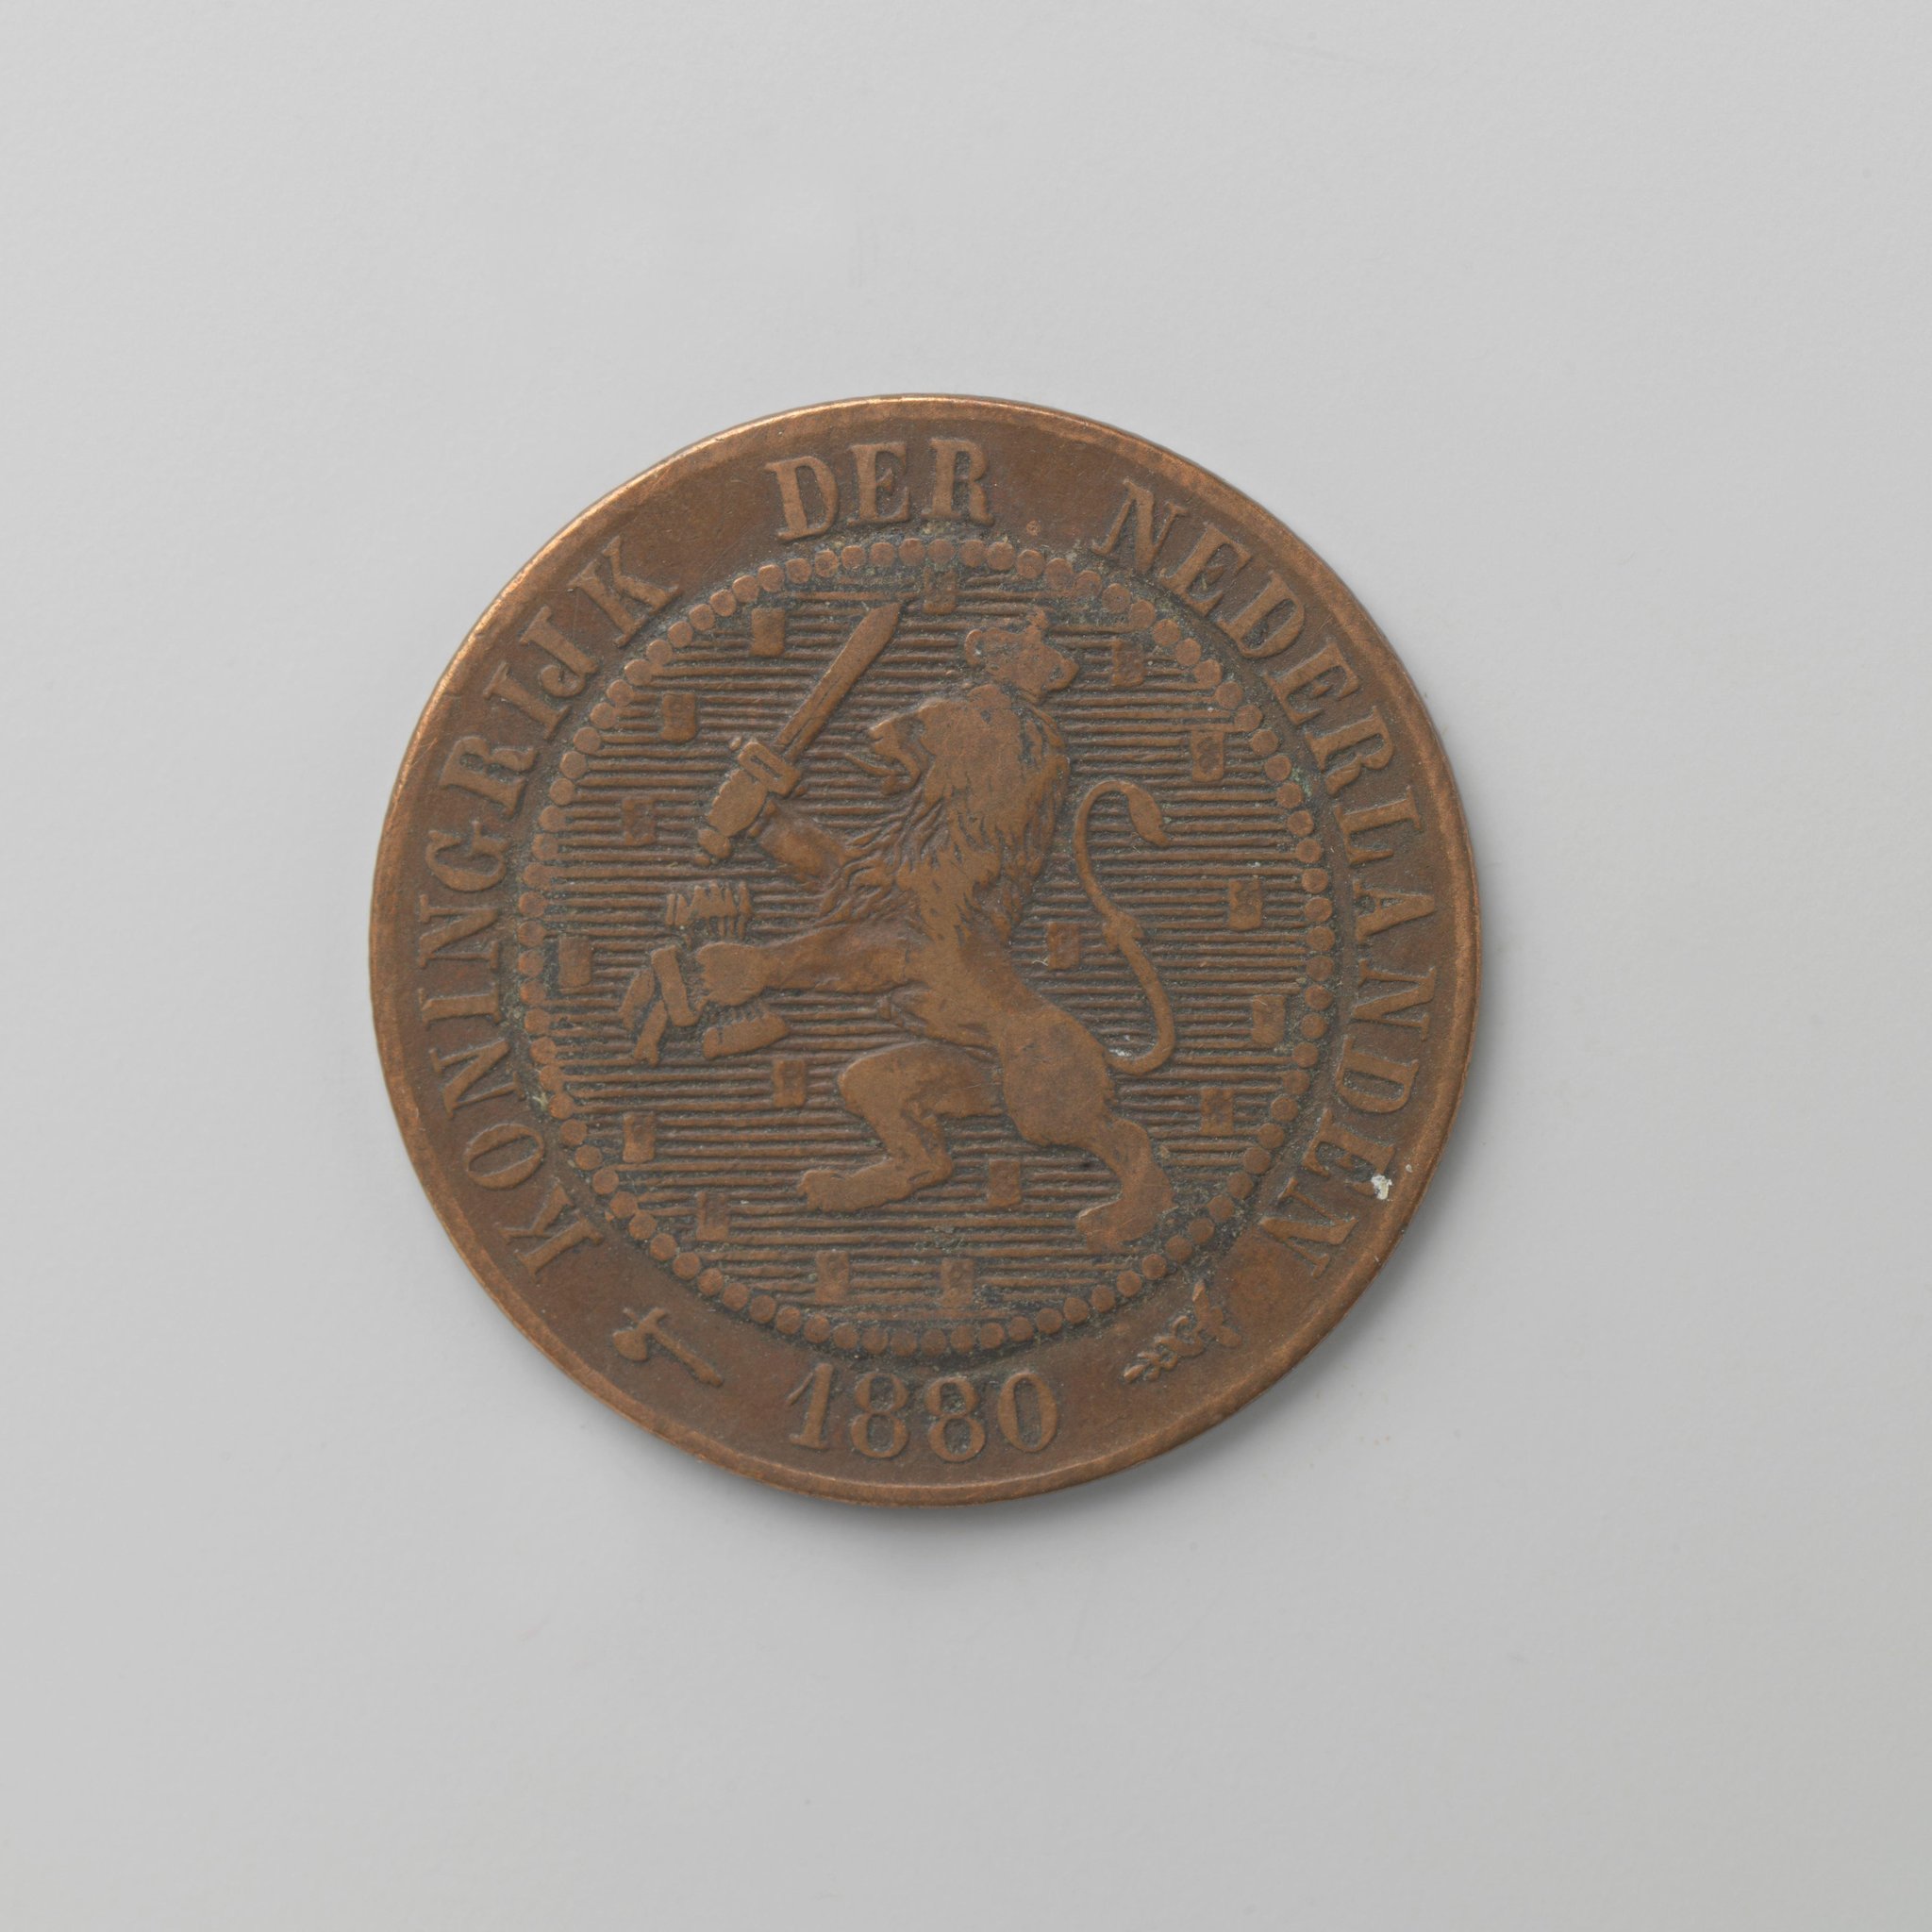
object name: coin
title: Nederland, 2½ cent, 1880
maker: willem iii (koning der nederlanden)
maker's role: koning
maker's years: 1817-1890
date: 1880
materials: bronze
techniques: striking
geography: utrecht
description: Bronzen munt. Voorzijde: in een veld rijkswapen. Jaartal onderaan in omschrift. Keerzijde: binnen twee samengebonden oranjetakken waarde-aanduiding 2½ cent. Kartelrand.